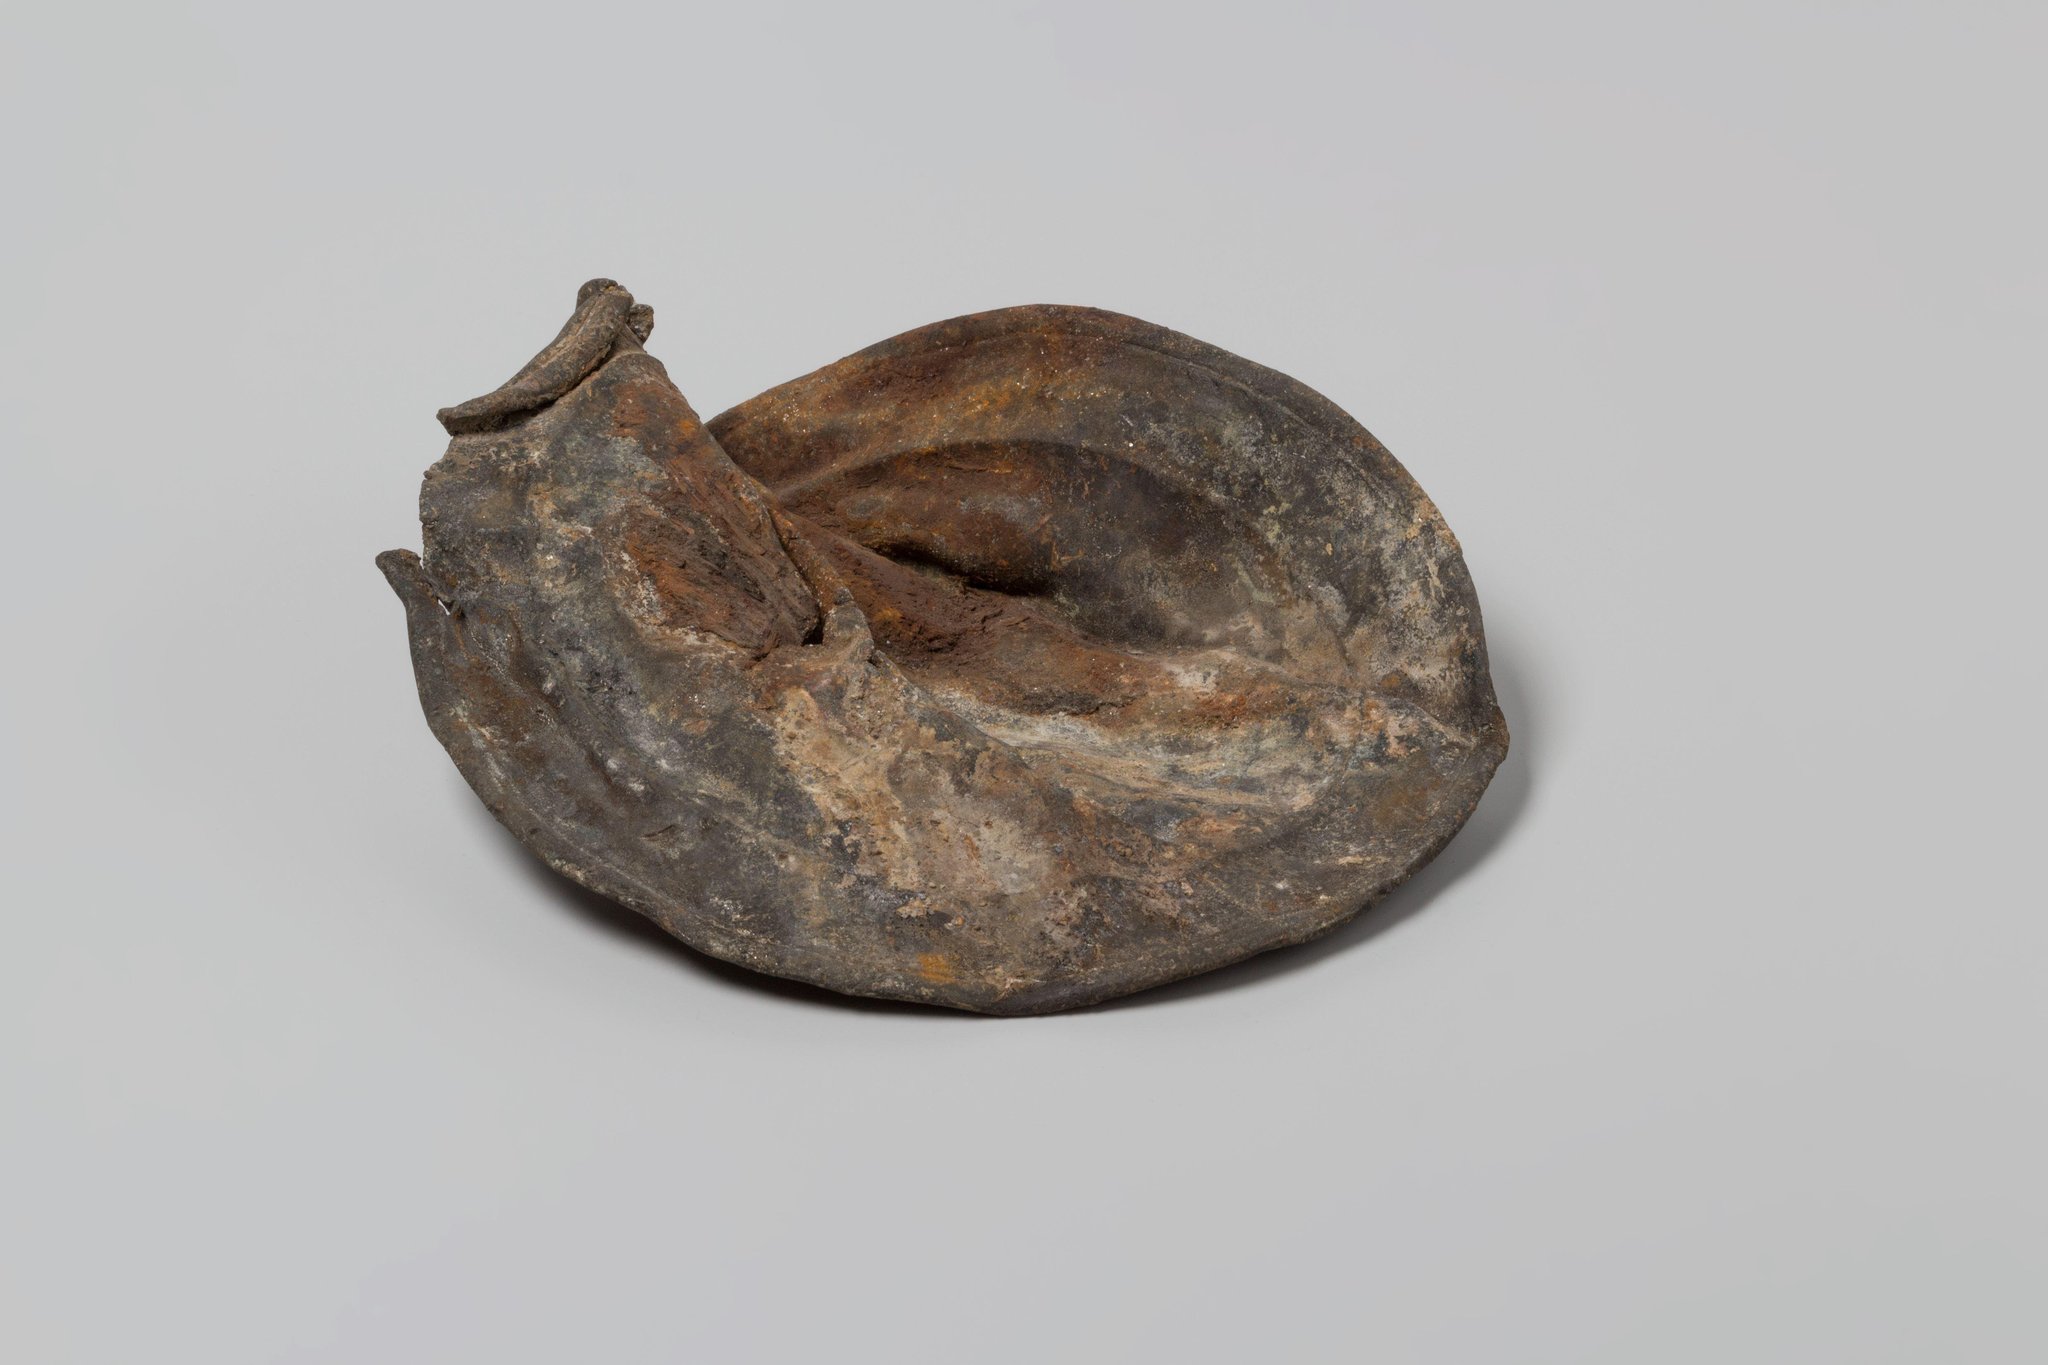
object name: plate dish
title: Bord uit het wrak van de Oost-Indiëvaarder Hollandia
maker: Anonymous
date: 1700-1743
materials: tin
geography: netherlands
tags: verenigde oostindische compagnie, hollandia (schip), annet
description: Plate, squashed, eroded, id. NG 1980-27H2288, no marks legible.